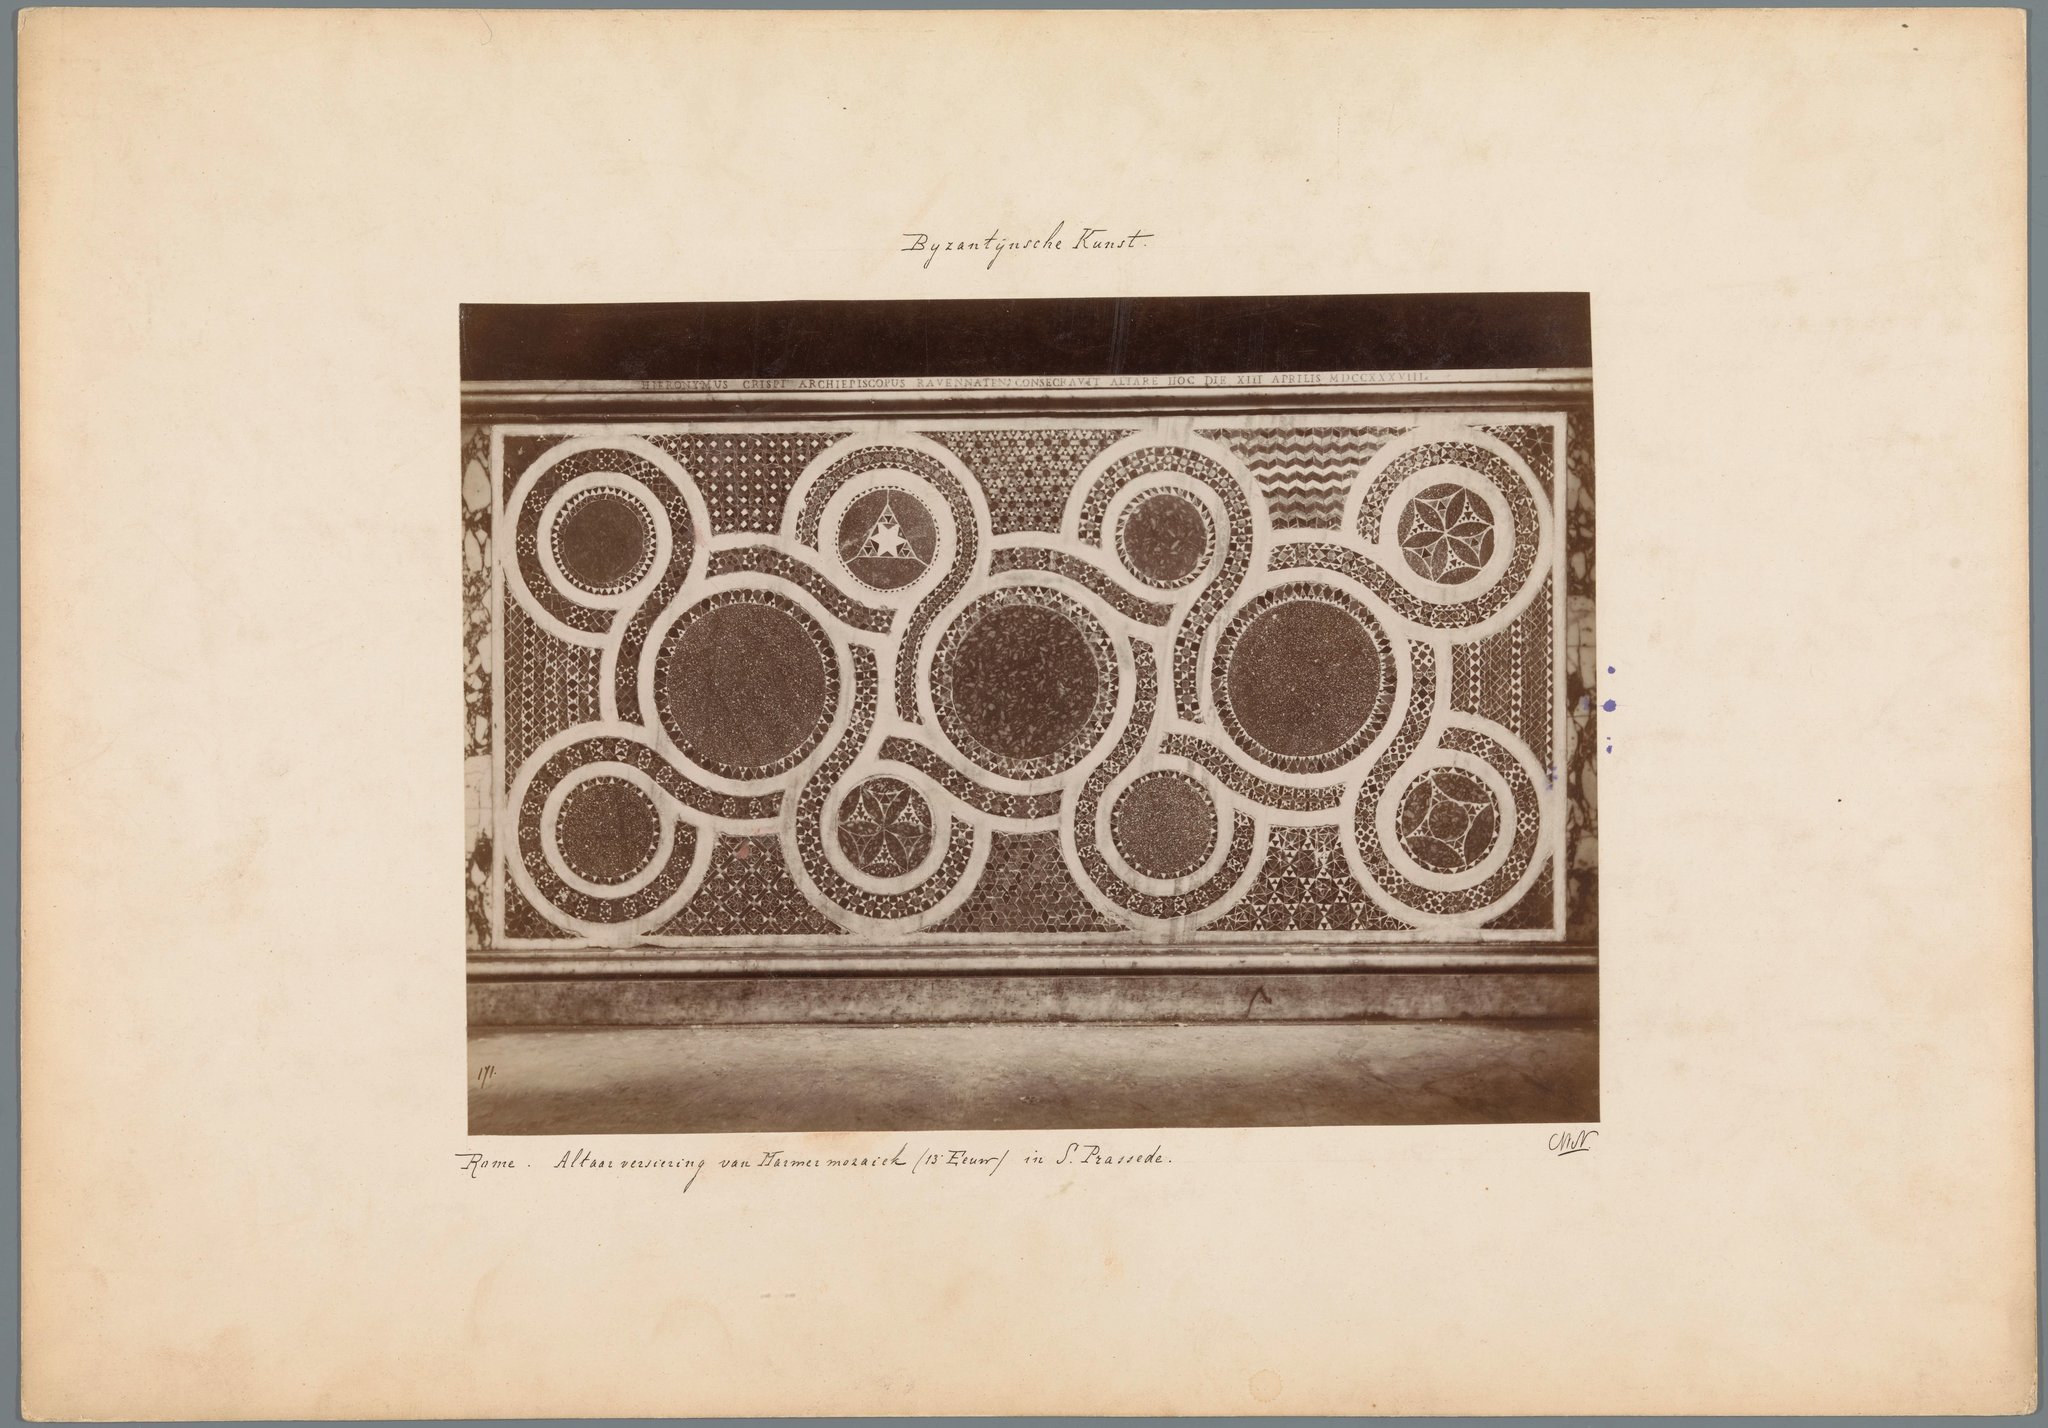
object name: photograph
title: Mozaïek op het altaar van de Santa Prassede te Rome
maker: Anonymous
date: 1875-1900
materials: cardboard, photographic support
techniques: albumen print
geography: basilica di santa prassede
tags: ornament ~ round and curved forms, art (+ mosaic making), interior of church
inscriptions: number: ‘171.’, collector's mark: ‘KUNSTNIJVERHEIDSCHOOL QUELLINUS AMSTERDAM FRANS HALSSTRAAT 14.’, inscription: ‘Byzantijnsche Kunst. Rome. Altaarversiering van Marmermozaiek (13e Eeuw) in S. Prassede.’, collector's mark: ‘INSTITUUT VOOR KUNST- NIJVERHEIDSONDERWIJS GABRIËL METSUSTRAAT No. 16. AMSTERDAM’, inscription: ‘CWN.’